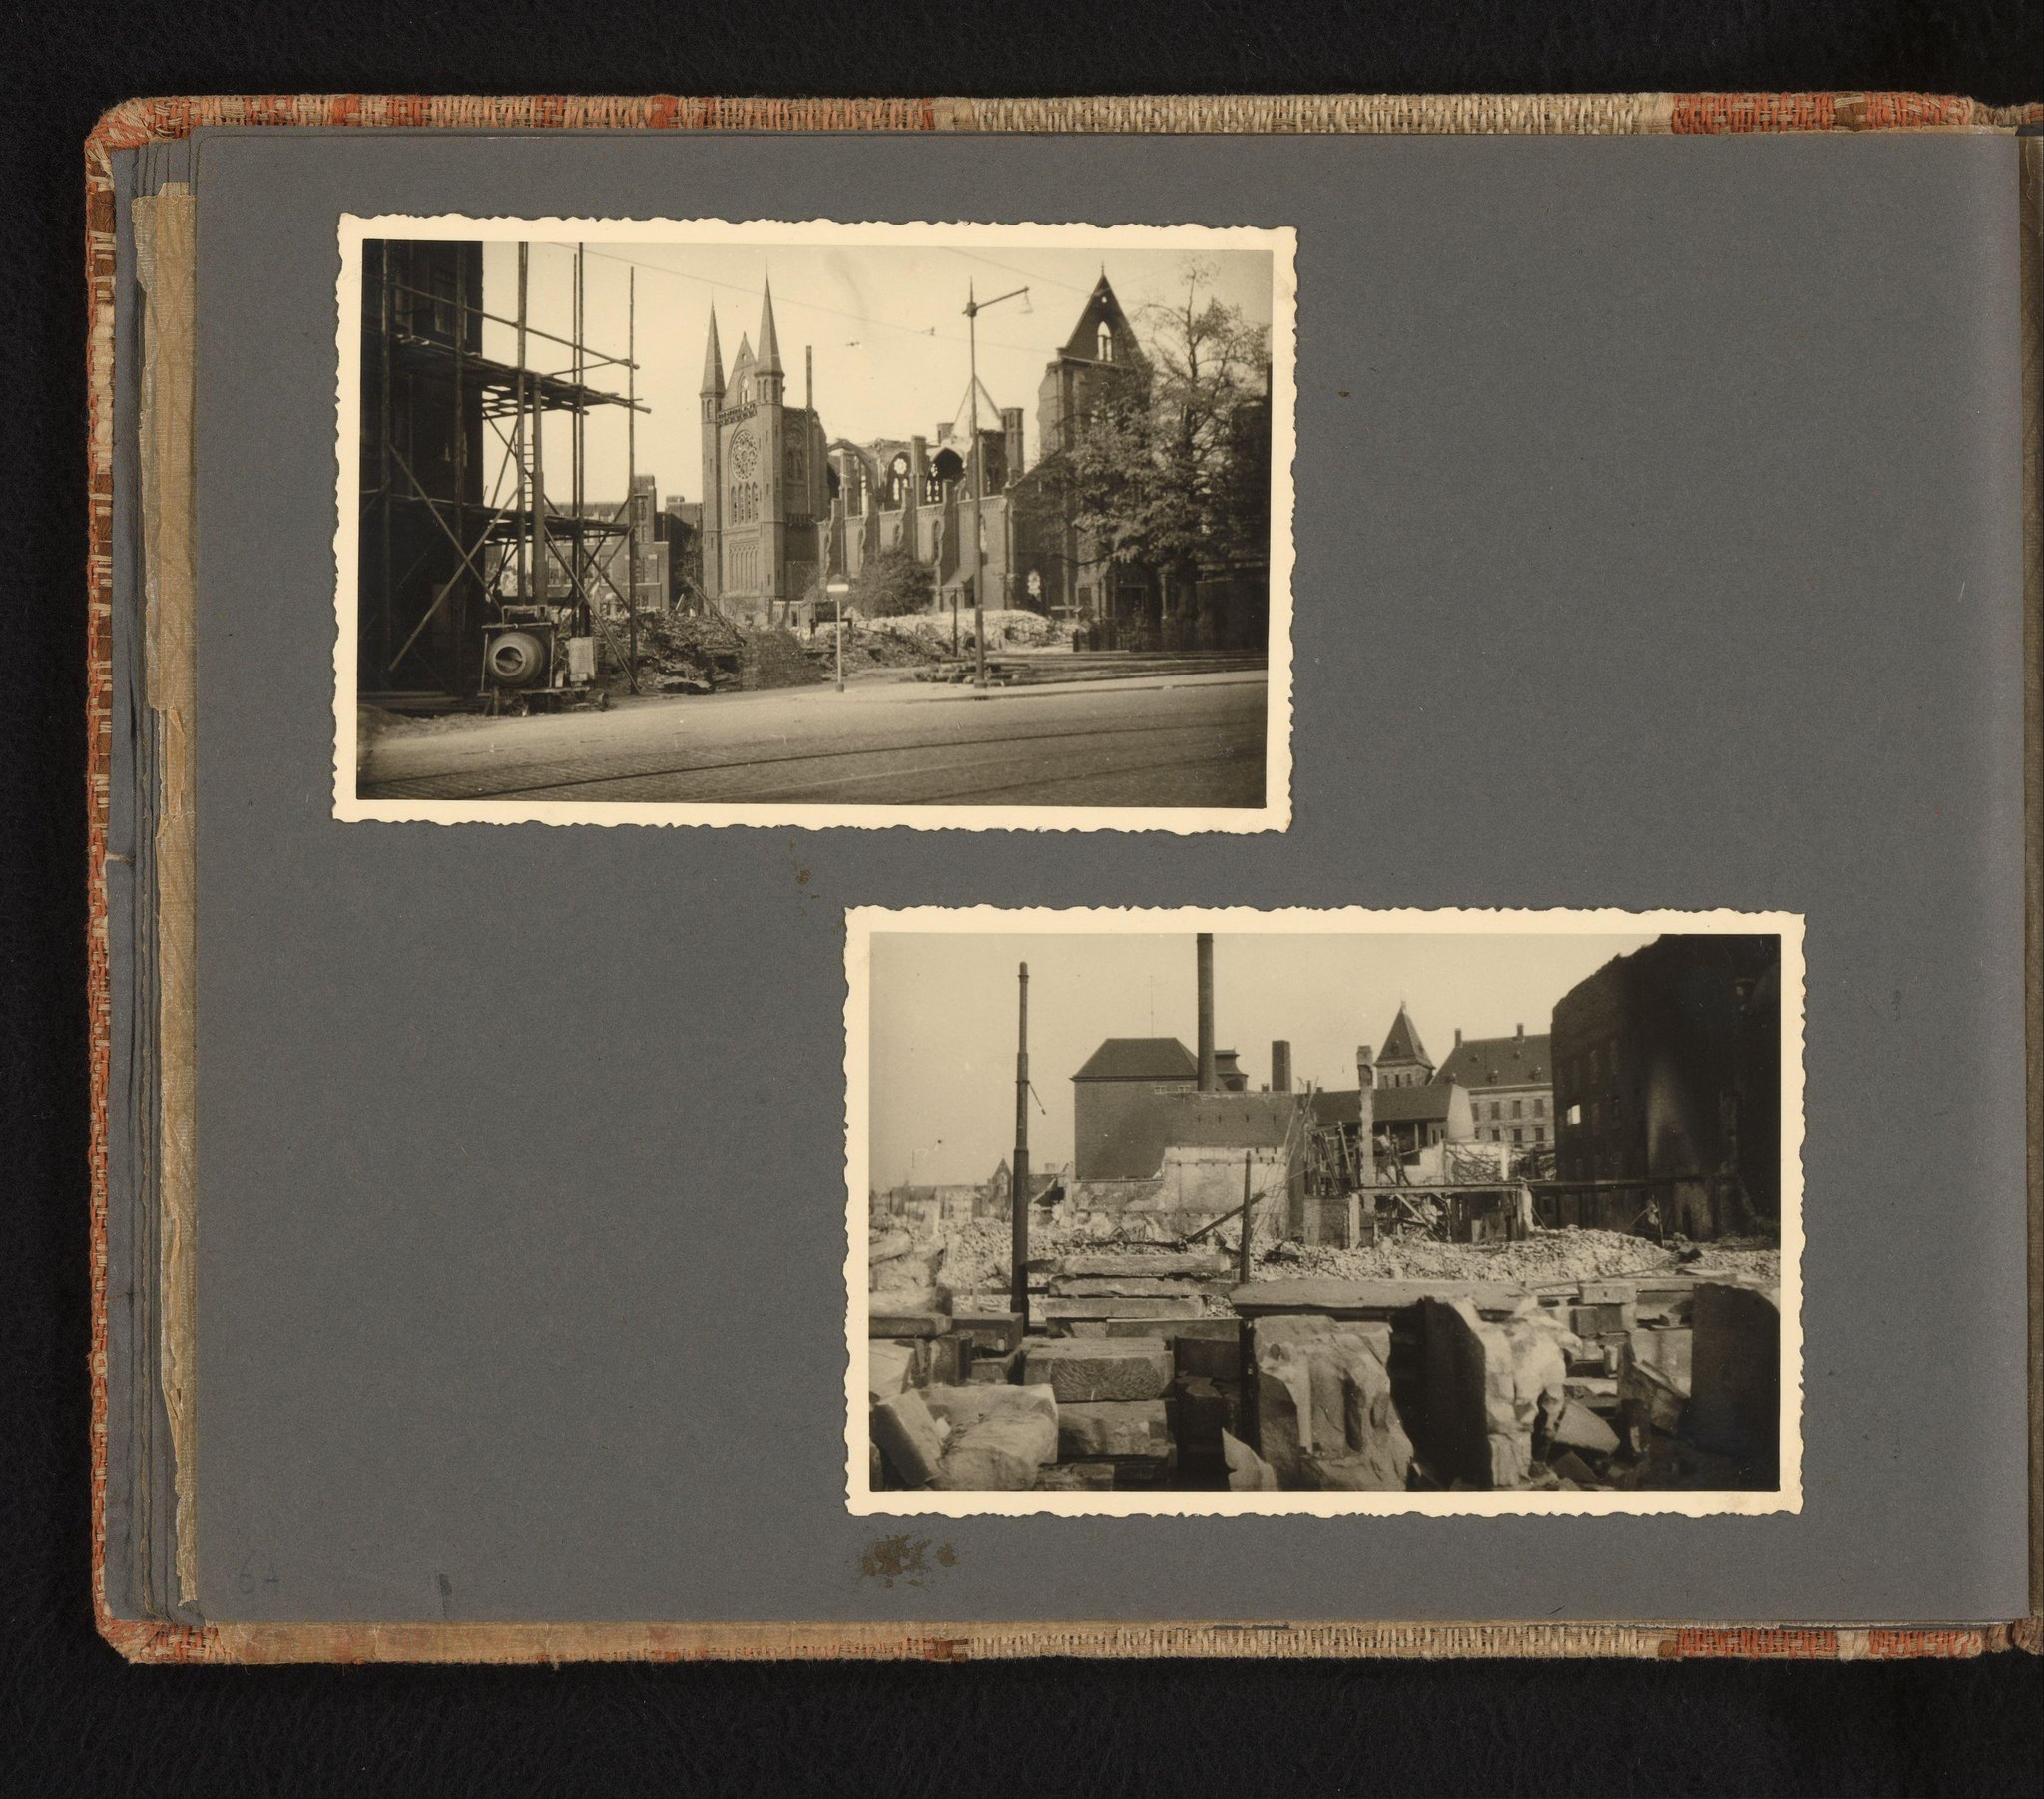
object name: ansichtkaart, prentbriefkaart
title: Oorlogsschade in Rotterdam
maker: Anonymous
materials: paper, photographic support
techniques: gelatin silver print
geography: rotterdam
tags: devastated, ruined place or city (~ warfare), rotterdam, rotterdam blitz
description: Albumblad met twee foto's van gebombardeerd Rotterdam. Onderdeel van het fotoalbum 'Kriegszeit in Holland' over de diensttijd in Nederland van Hans Heinemann van een Flak Regiment van de Luftverteidigungskommando van de Luftwaffe.